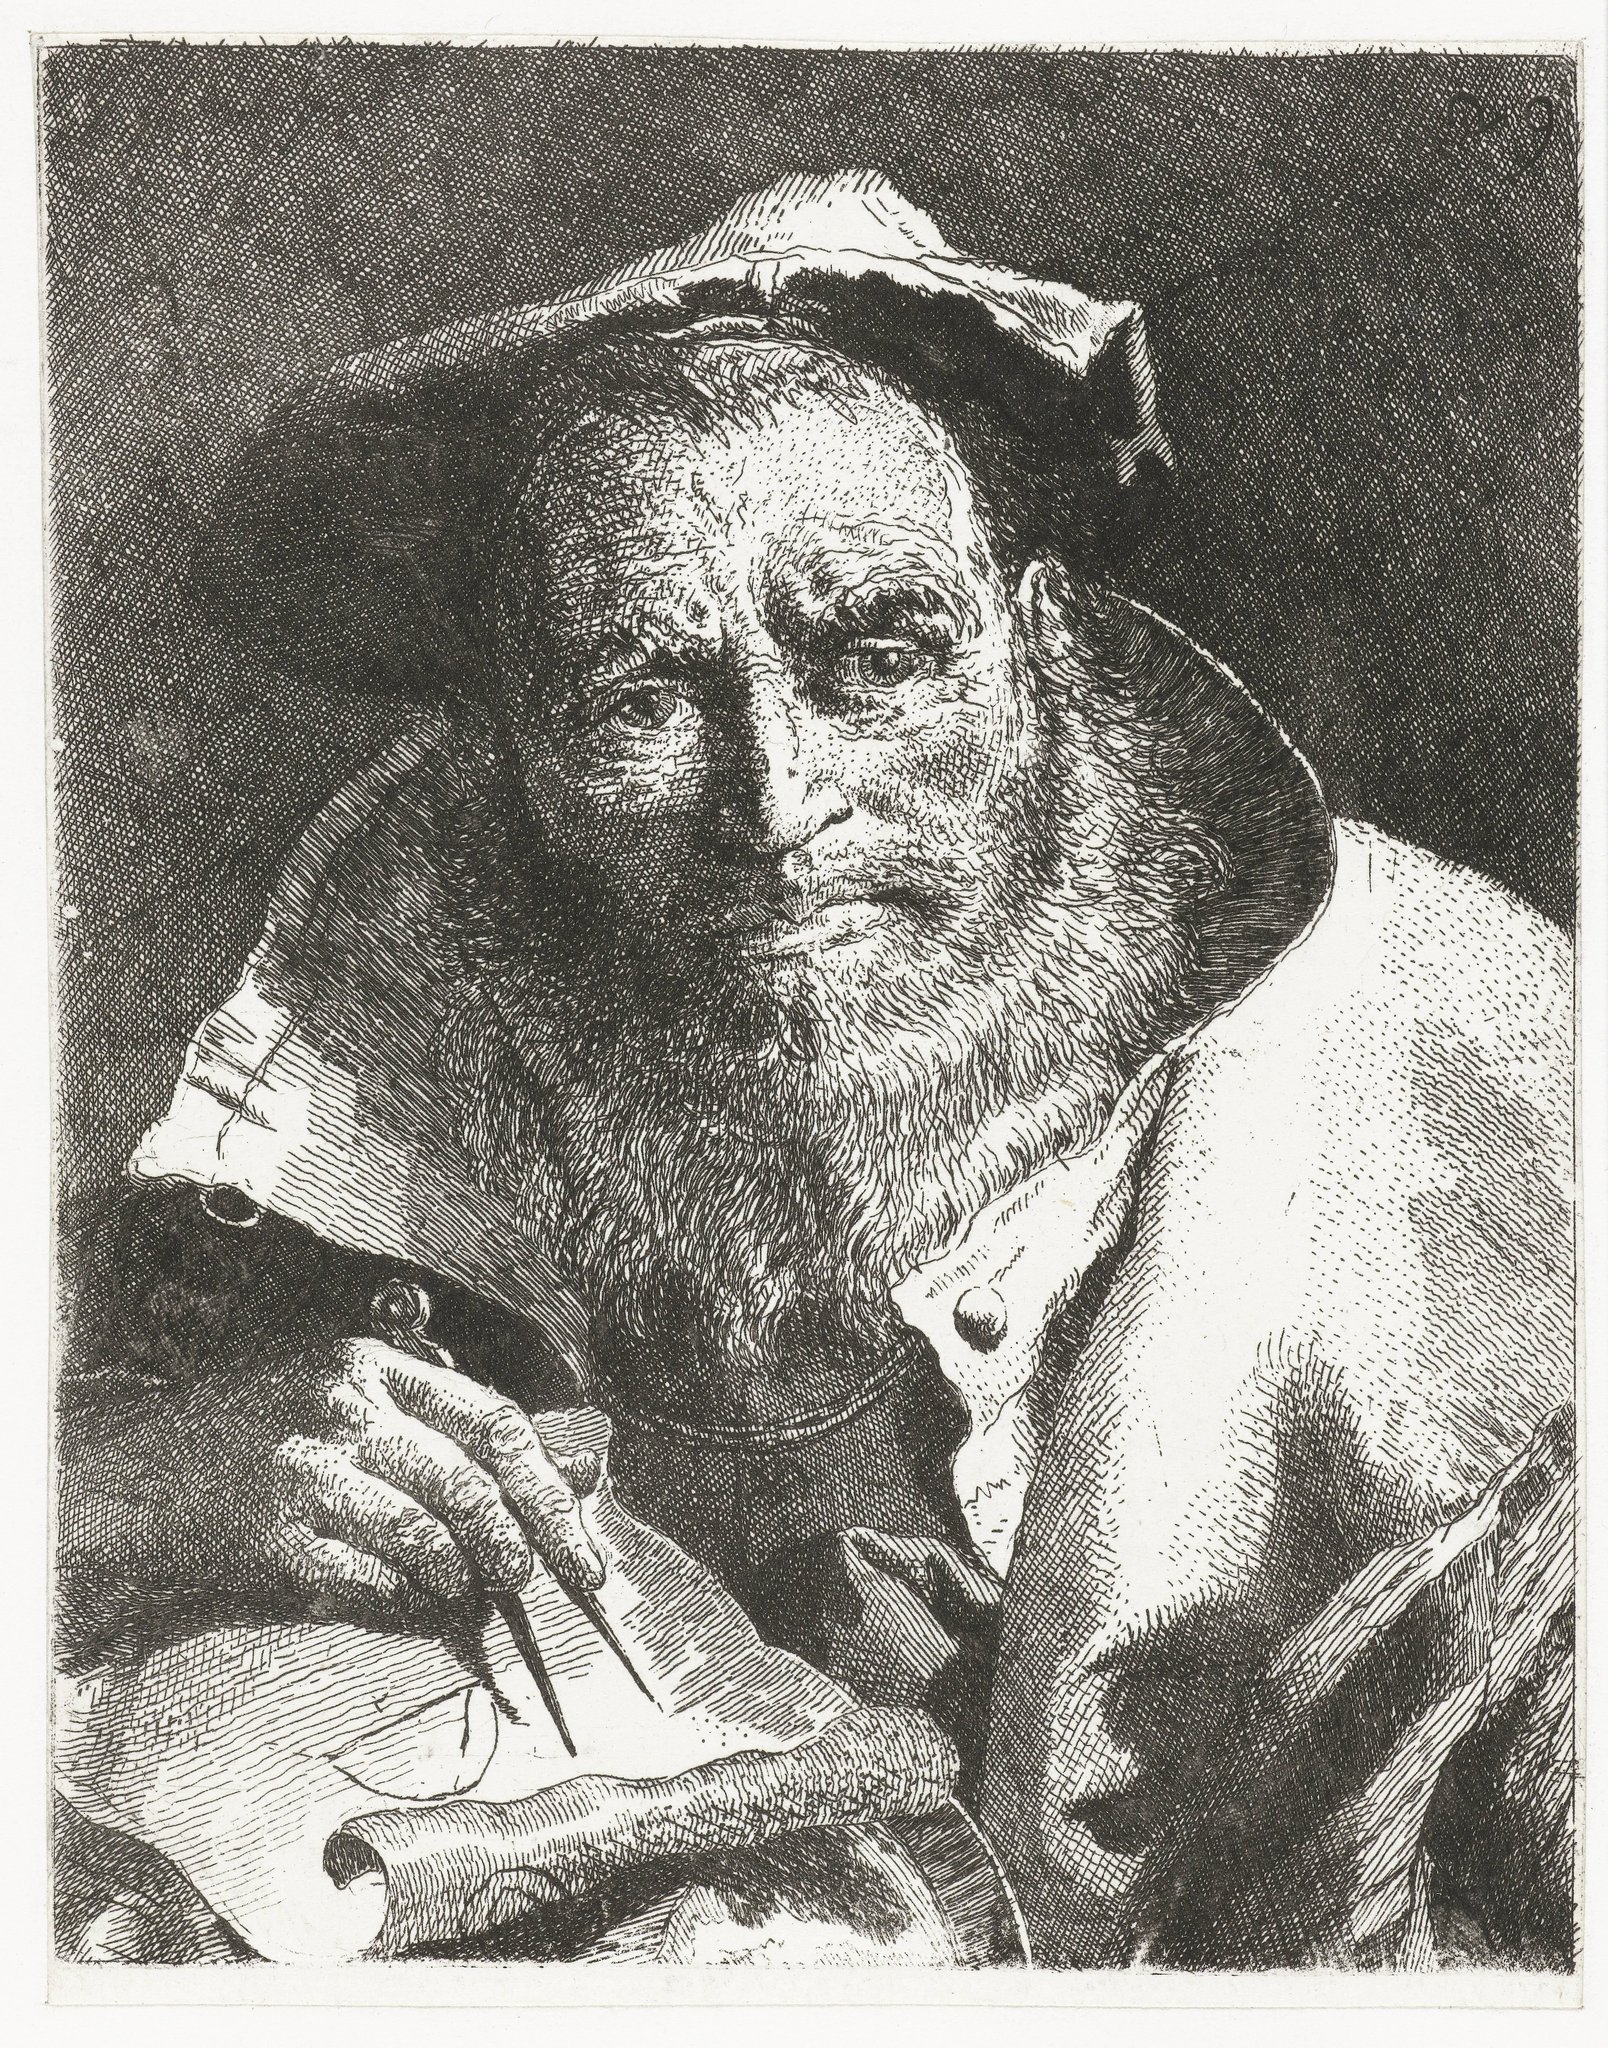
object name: print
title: Verzameling hoofden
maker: giovanni domenico tiepolo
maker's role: draughtsman, print maker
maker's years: 1727-1804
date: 1756-1757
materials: paper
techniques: etching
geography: venice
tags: compasses, mathematics (+ scholar, scientist (at work))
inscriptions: collector's mark: Lugt 2228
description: Prent uit serie Verzameling hoofden (Raccolta di teste). Giovanni Domenico Tiepolo vervaardigde in de winter van 1757-1758 en in de periode van 1771-1774 deze hoofden naar schilderijen en tekeningen van Giovanni Battista Tiepolo. De eerste uitgave verscheen in 1774 in twee delen met elk dertig prenten. Deze prent werd opgenomen in deel 1.